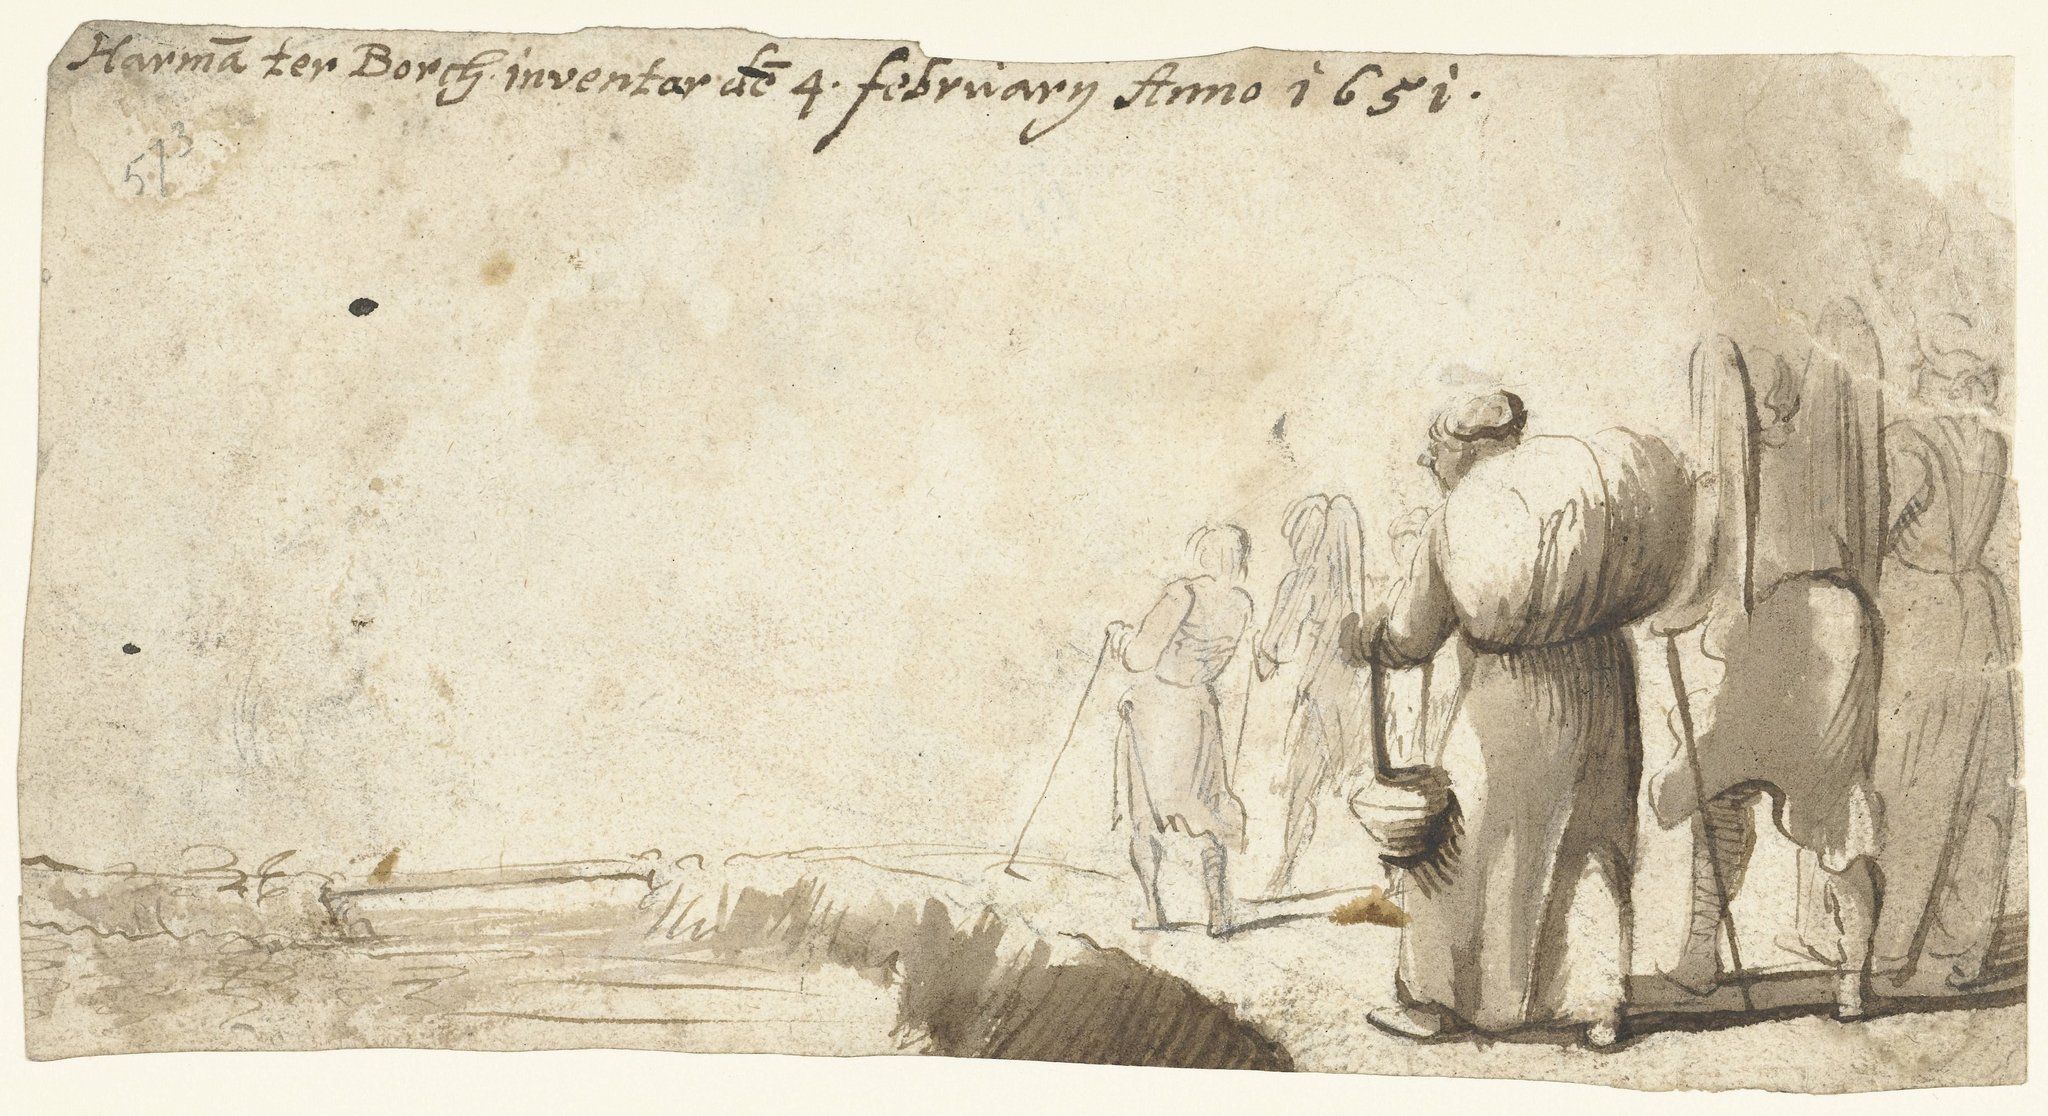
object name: drawing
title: Uittocht van Lot en zijn dochters, van achteren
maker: harmen ter borch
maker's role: draughtsman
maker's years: 1638-1677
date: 1651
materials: chalk, paint, gouache, ink, paper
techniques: brush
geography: zwolle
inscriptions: annotation: ‘Harma[n] ter Borch. inventor de[n] 4.februarij Anno 1651.’